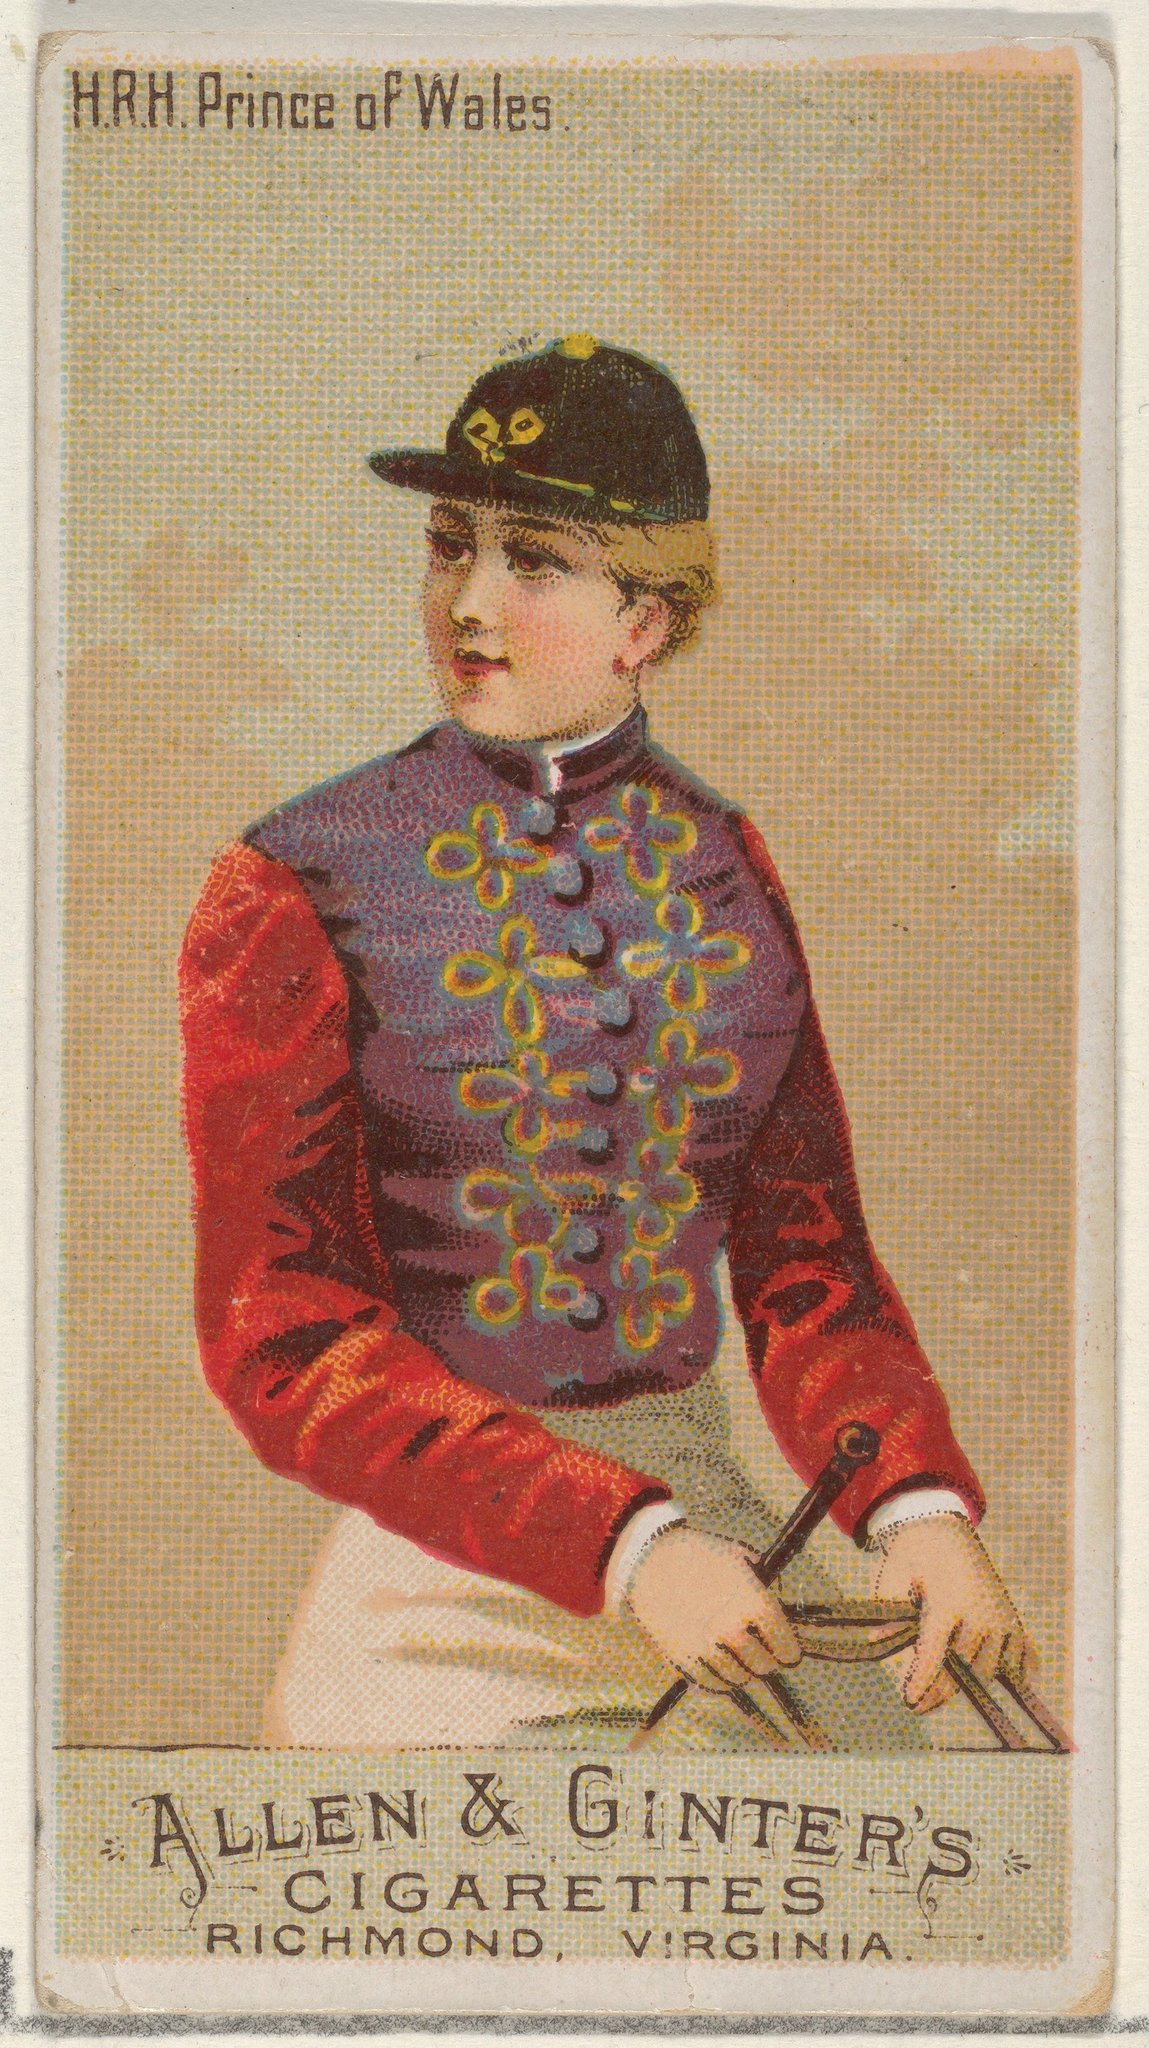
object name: print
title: H.R.H. Prince of Wales, from the Racing Colors of the World series (N22a) for Allen & Ginter Cigarettes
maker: allen & ginter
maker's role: publisher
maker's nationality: american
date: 1888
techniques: color lithograph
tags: men,jockeys